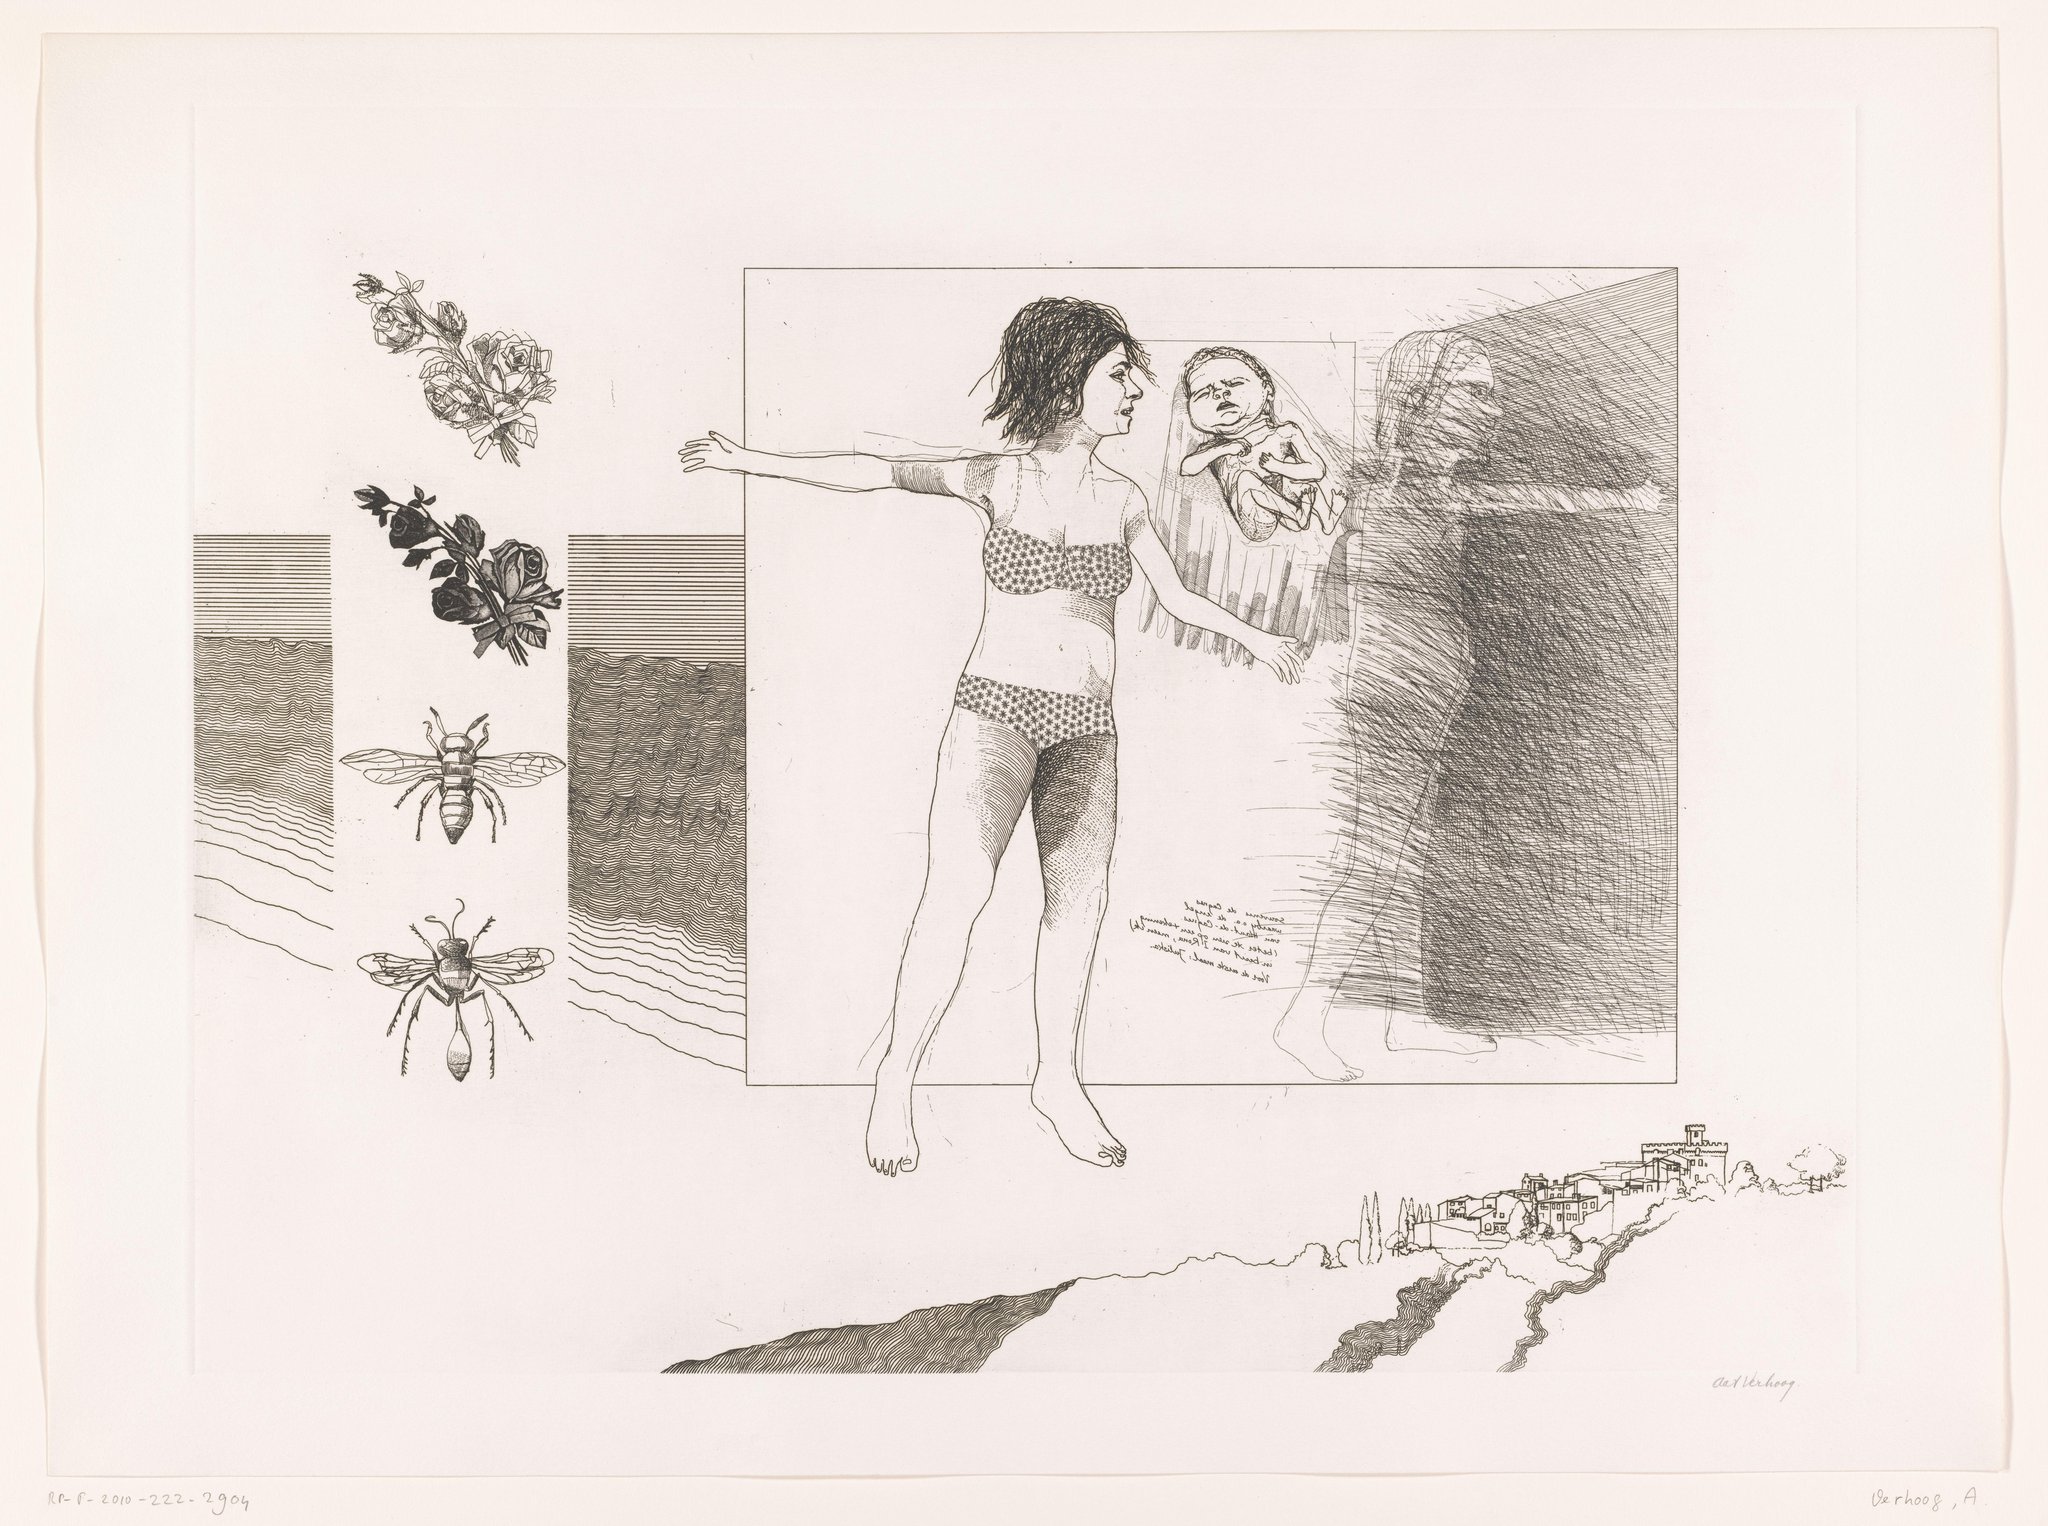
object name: print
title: Vrouw met baby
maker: aat verhoog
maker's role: print maker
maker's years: 1933-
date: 1965-2009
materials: paper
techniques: etching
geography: amsterdam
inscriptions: signature: ‘Aat Verhoog’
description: Staande vrouw in ondergoed bij zwevende baby, links rozen en insecten en onder het silhouet van een Toscaanse stad.